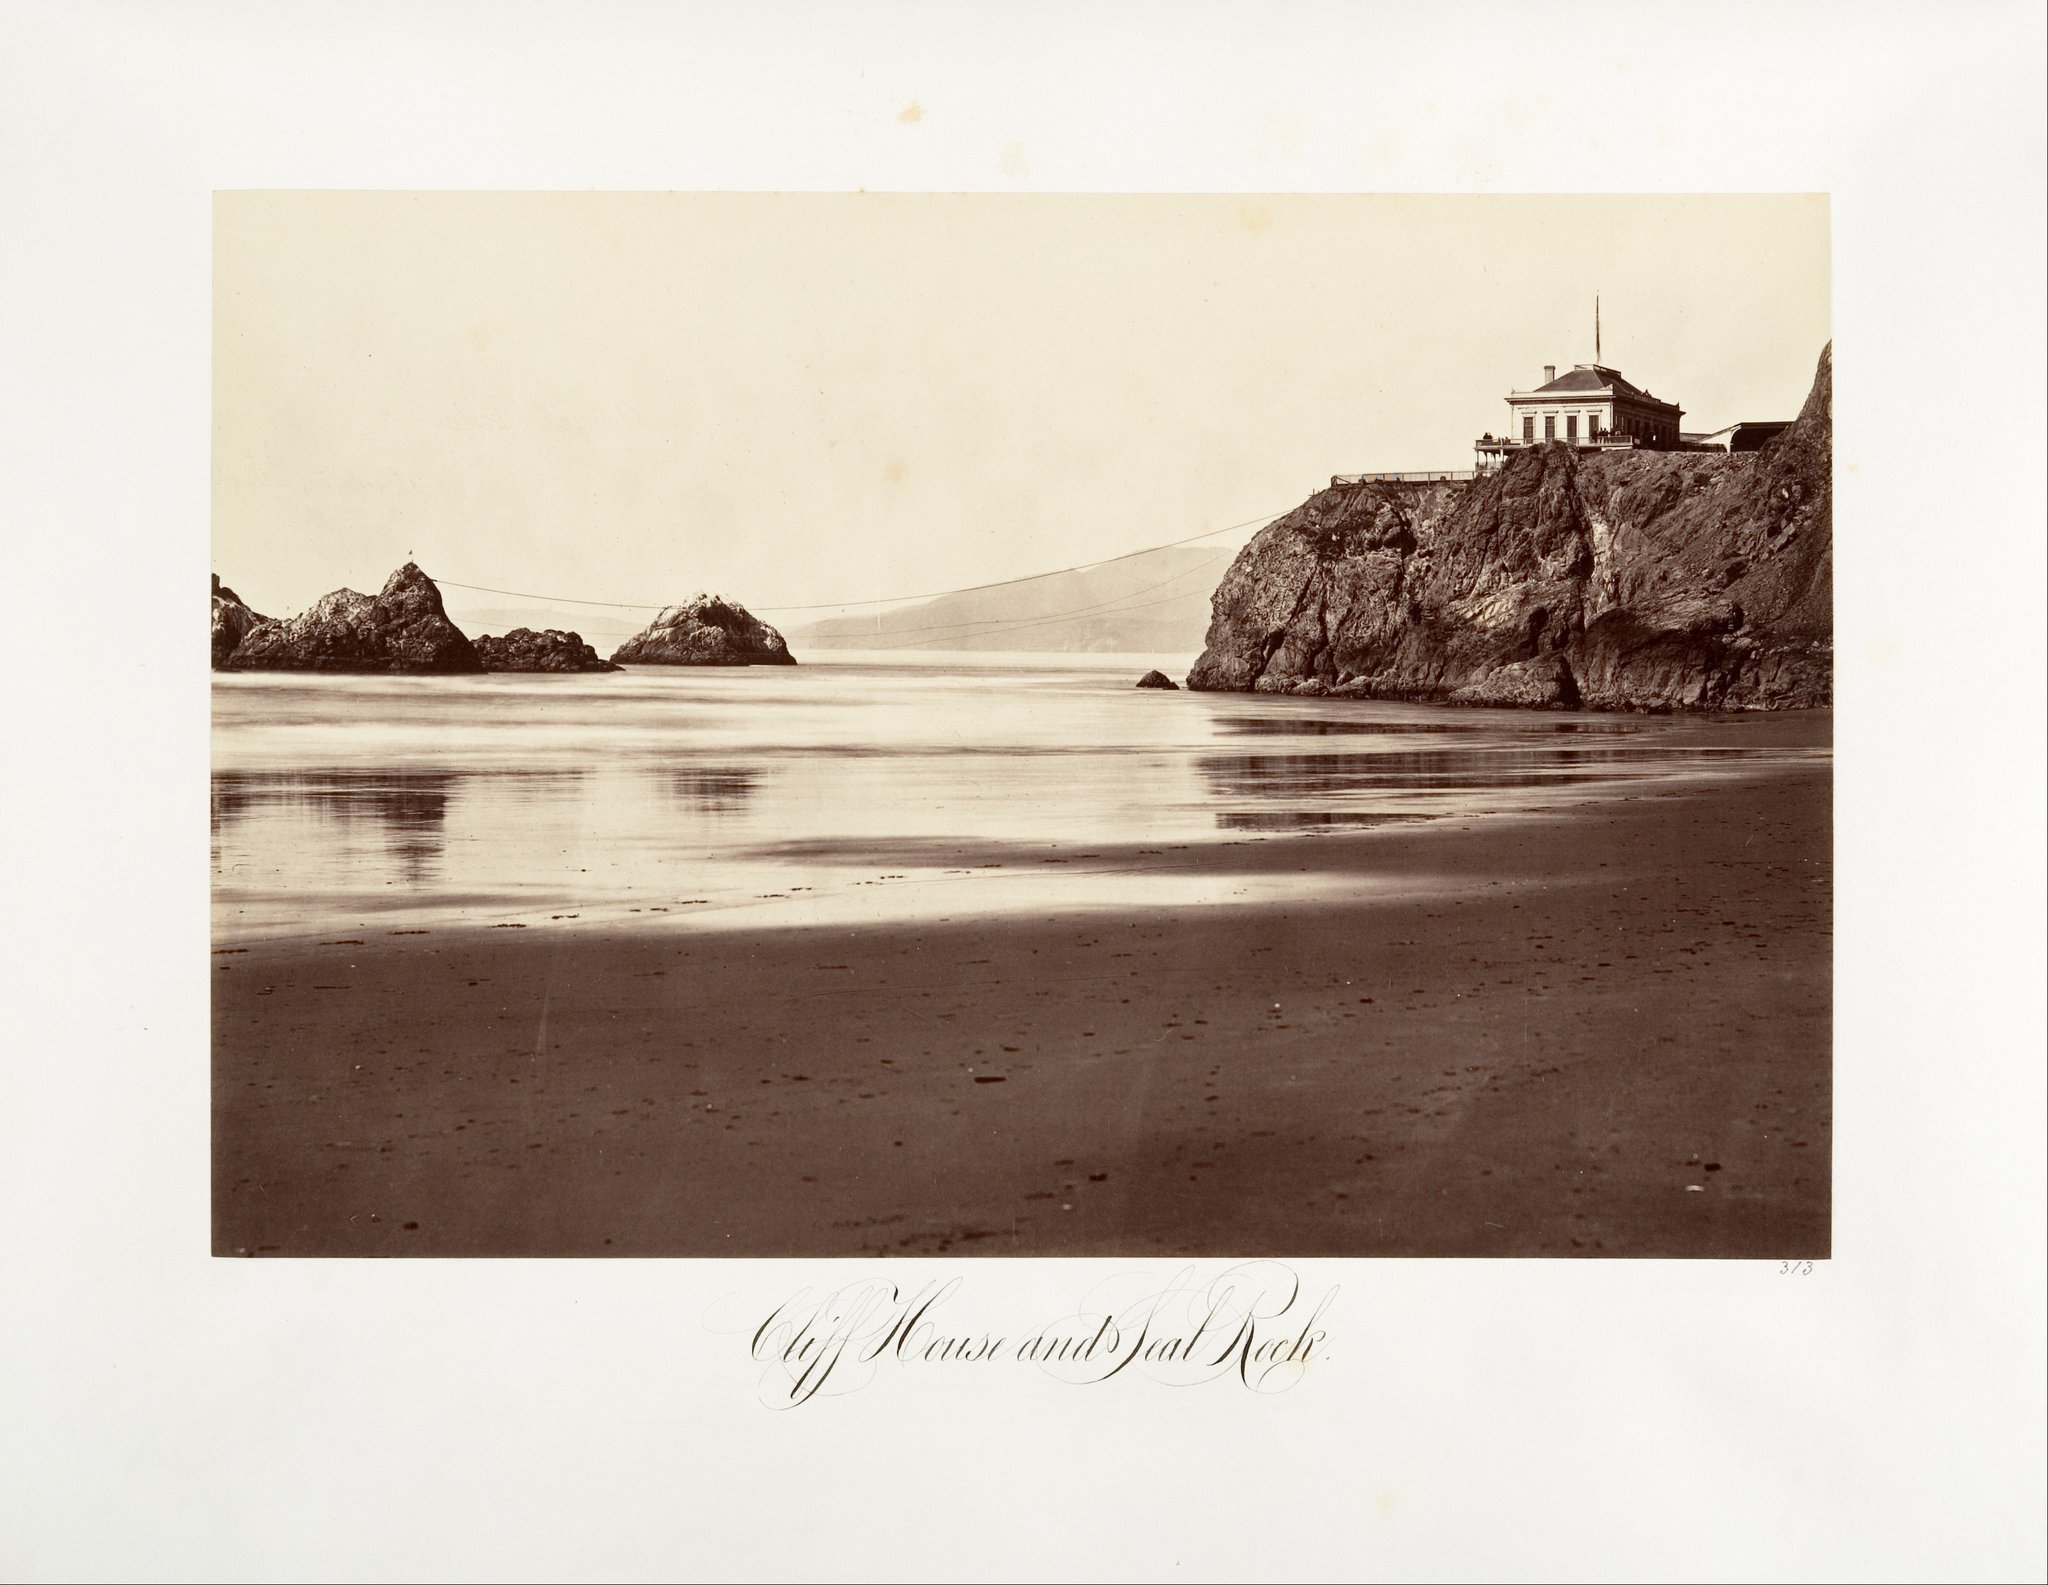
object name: photograph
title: Cliff House and Seal Rock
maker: carleton e. watkins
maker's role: artist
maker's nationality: american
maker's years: 1829-1916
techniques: albumen silver print, glass negative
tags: houses,landscapes